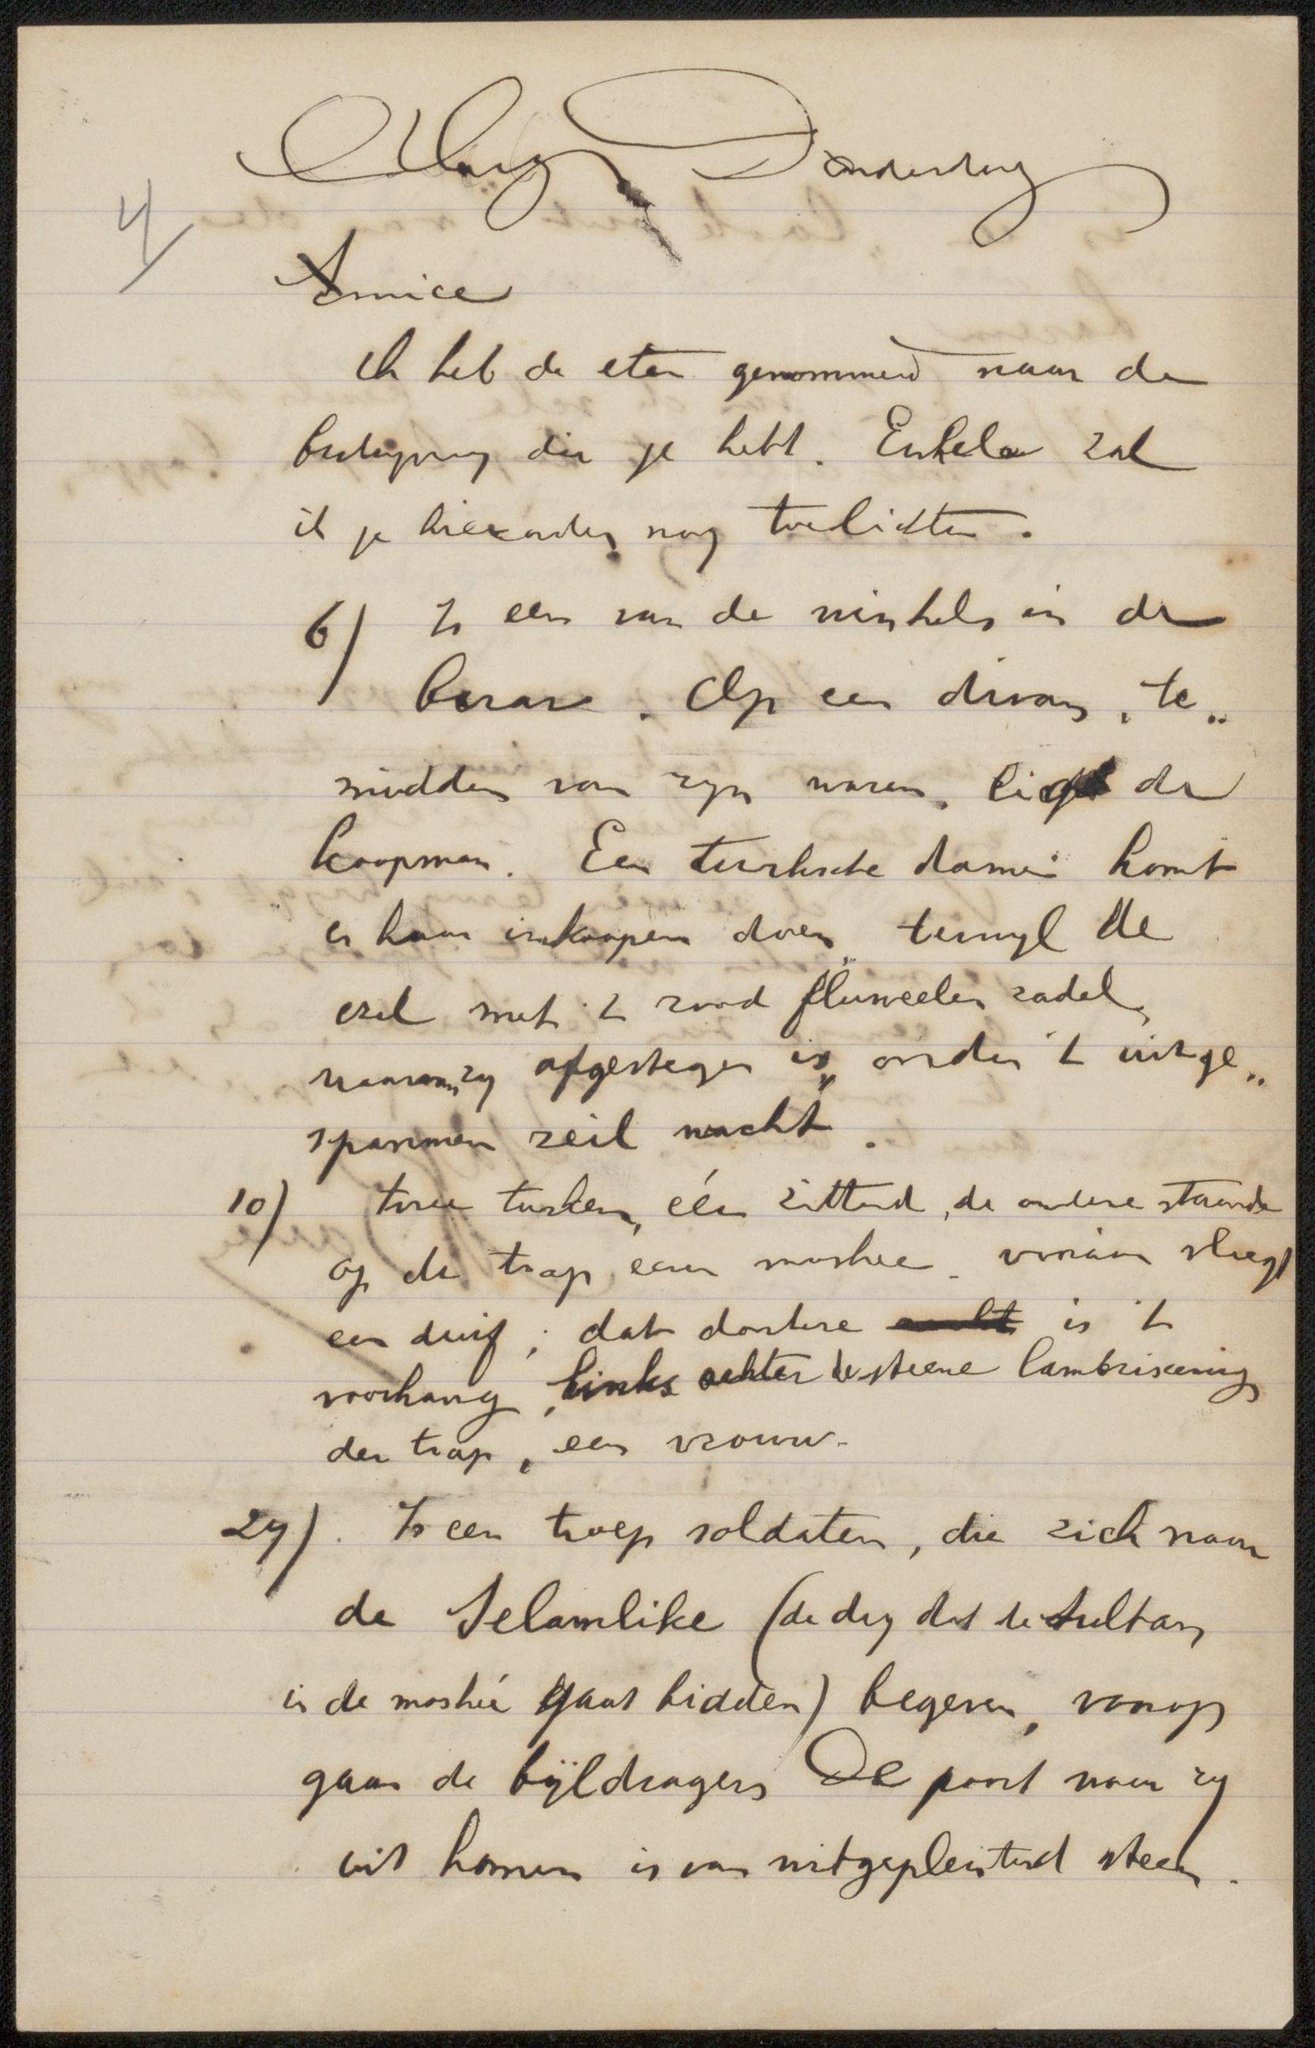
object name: letter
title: Brief aan Jan Veth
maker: marius bauer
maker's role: draughtsman, print maker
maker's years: 1867-1932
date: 1877-1925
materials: ink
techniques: pen, writing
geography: the hague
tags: dordrecht, amsterdam, painter, print maker, draughtsman, designer, jan veth, the graphic arts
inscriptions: collector's mark: ‘RPK’